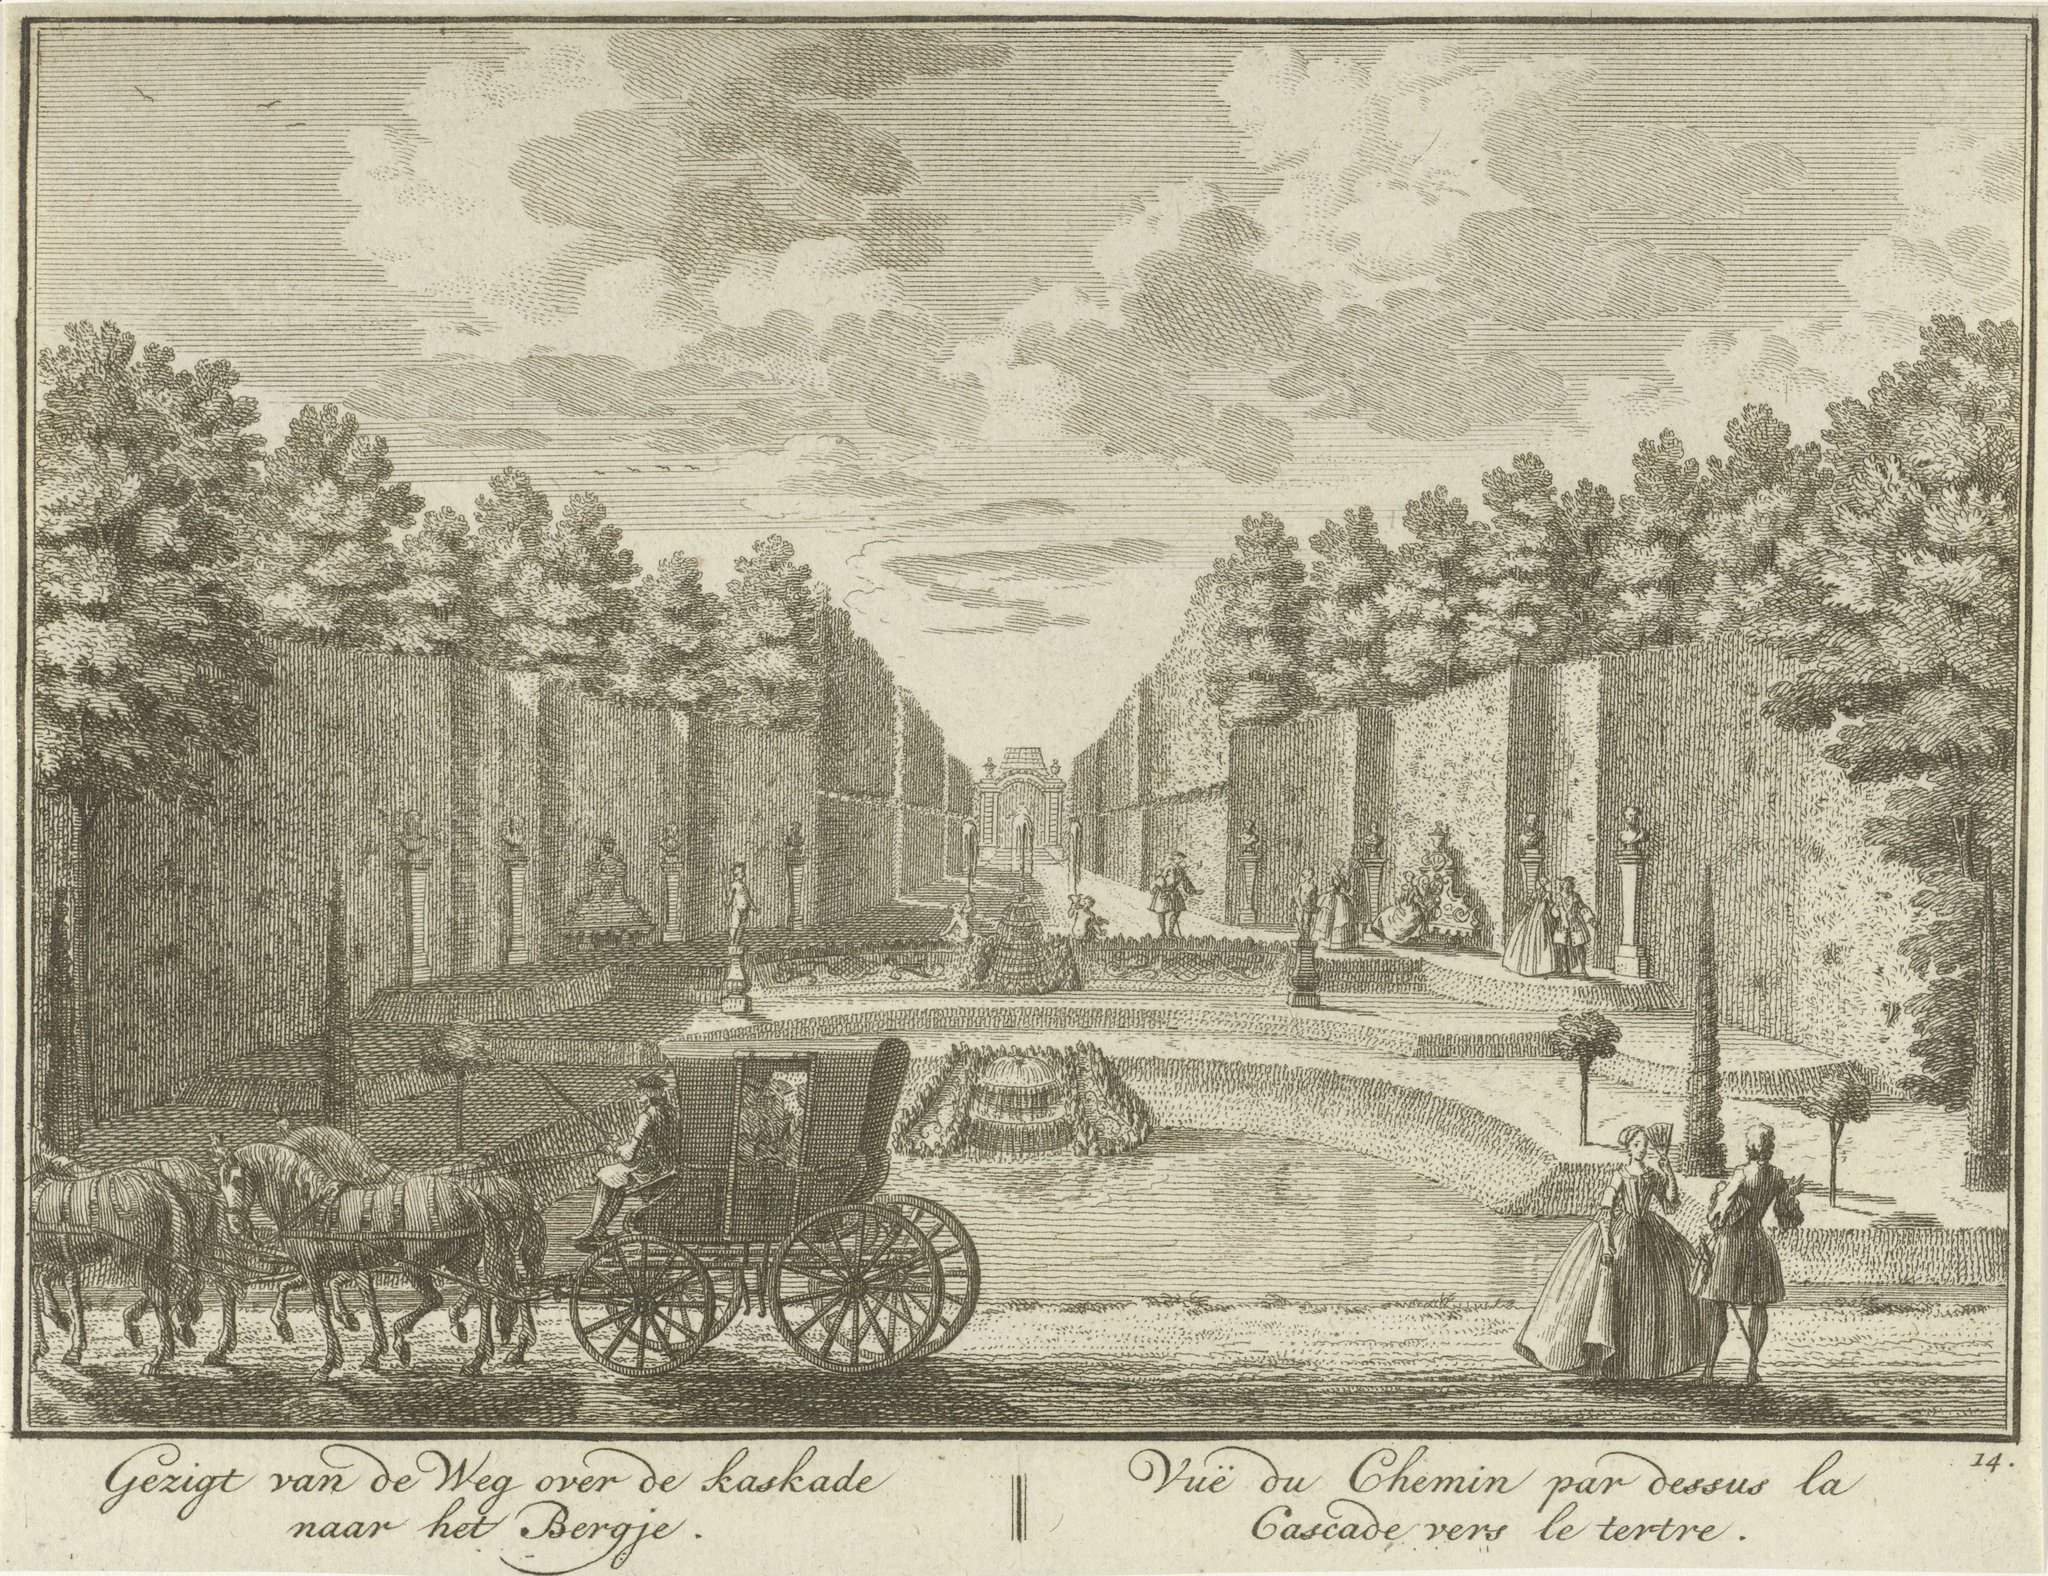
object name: print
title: Gezicht op een vijver in de tuin van Huis ter Meer te Maarssen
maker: hendrik de leth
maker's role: draughtsman, print maker, publisher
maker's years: 1703-1766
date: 1740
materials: paper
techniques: etching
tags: garden fountain, french or architectonic garden; formal garden, country-house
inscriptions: collector's mark: Lugt 2228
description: Gezicht op een symmetrisch aangelegde vijver in de Franse tuin van Huis ter Meer. Op de voorgrond wordt een koets door paarden voortgetrokken, rechts een converserende man en vrouw. De prent maakt deel uit van een serie met 26 gezichten op Huis ter Meer en het bijbehorende landgoed te Maarssen.